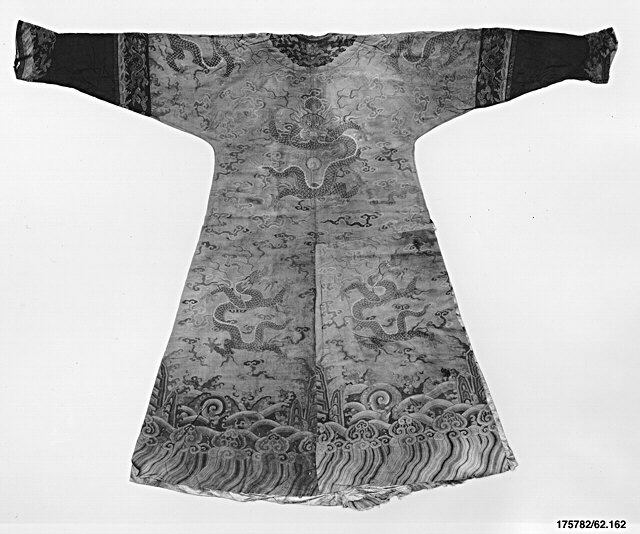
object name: woman's dragon robe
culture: chinese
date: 1723-1735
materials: metal thread, silk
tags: dragons